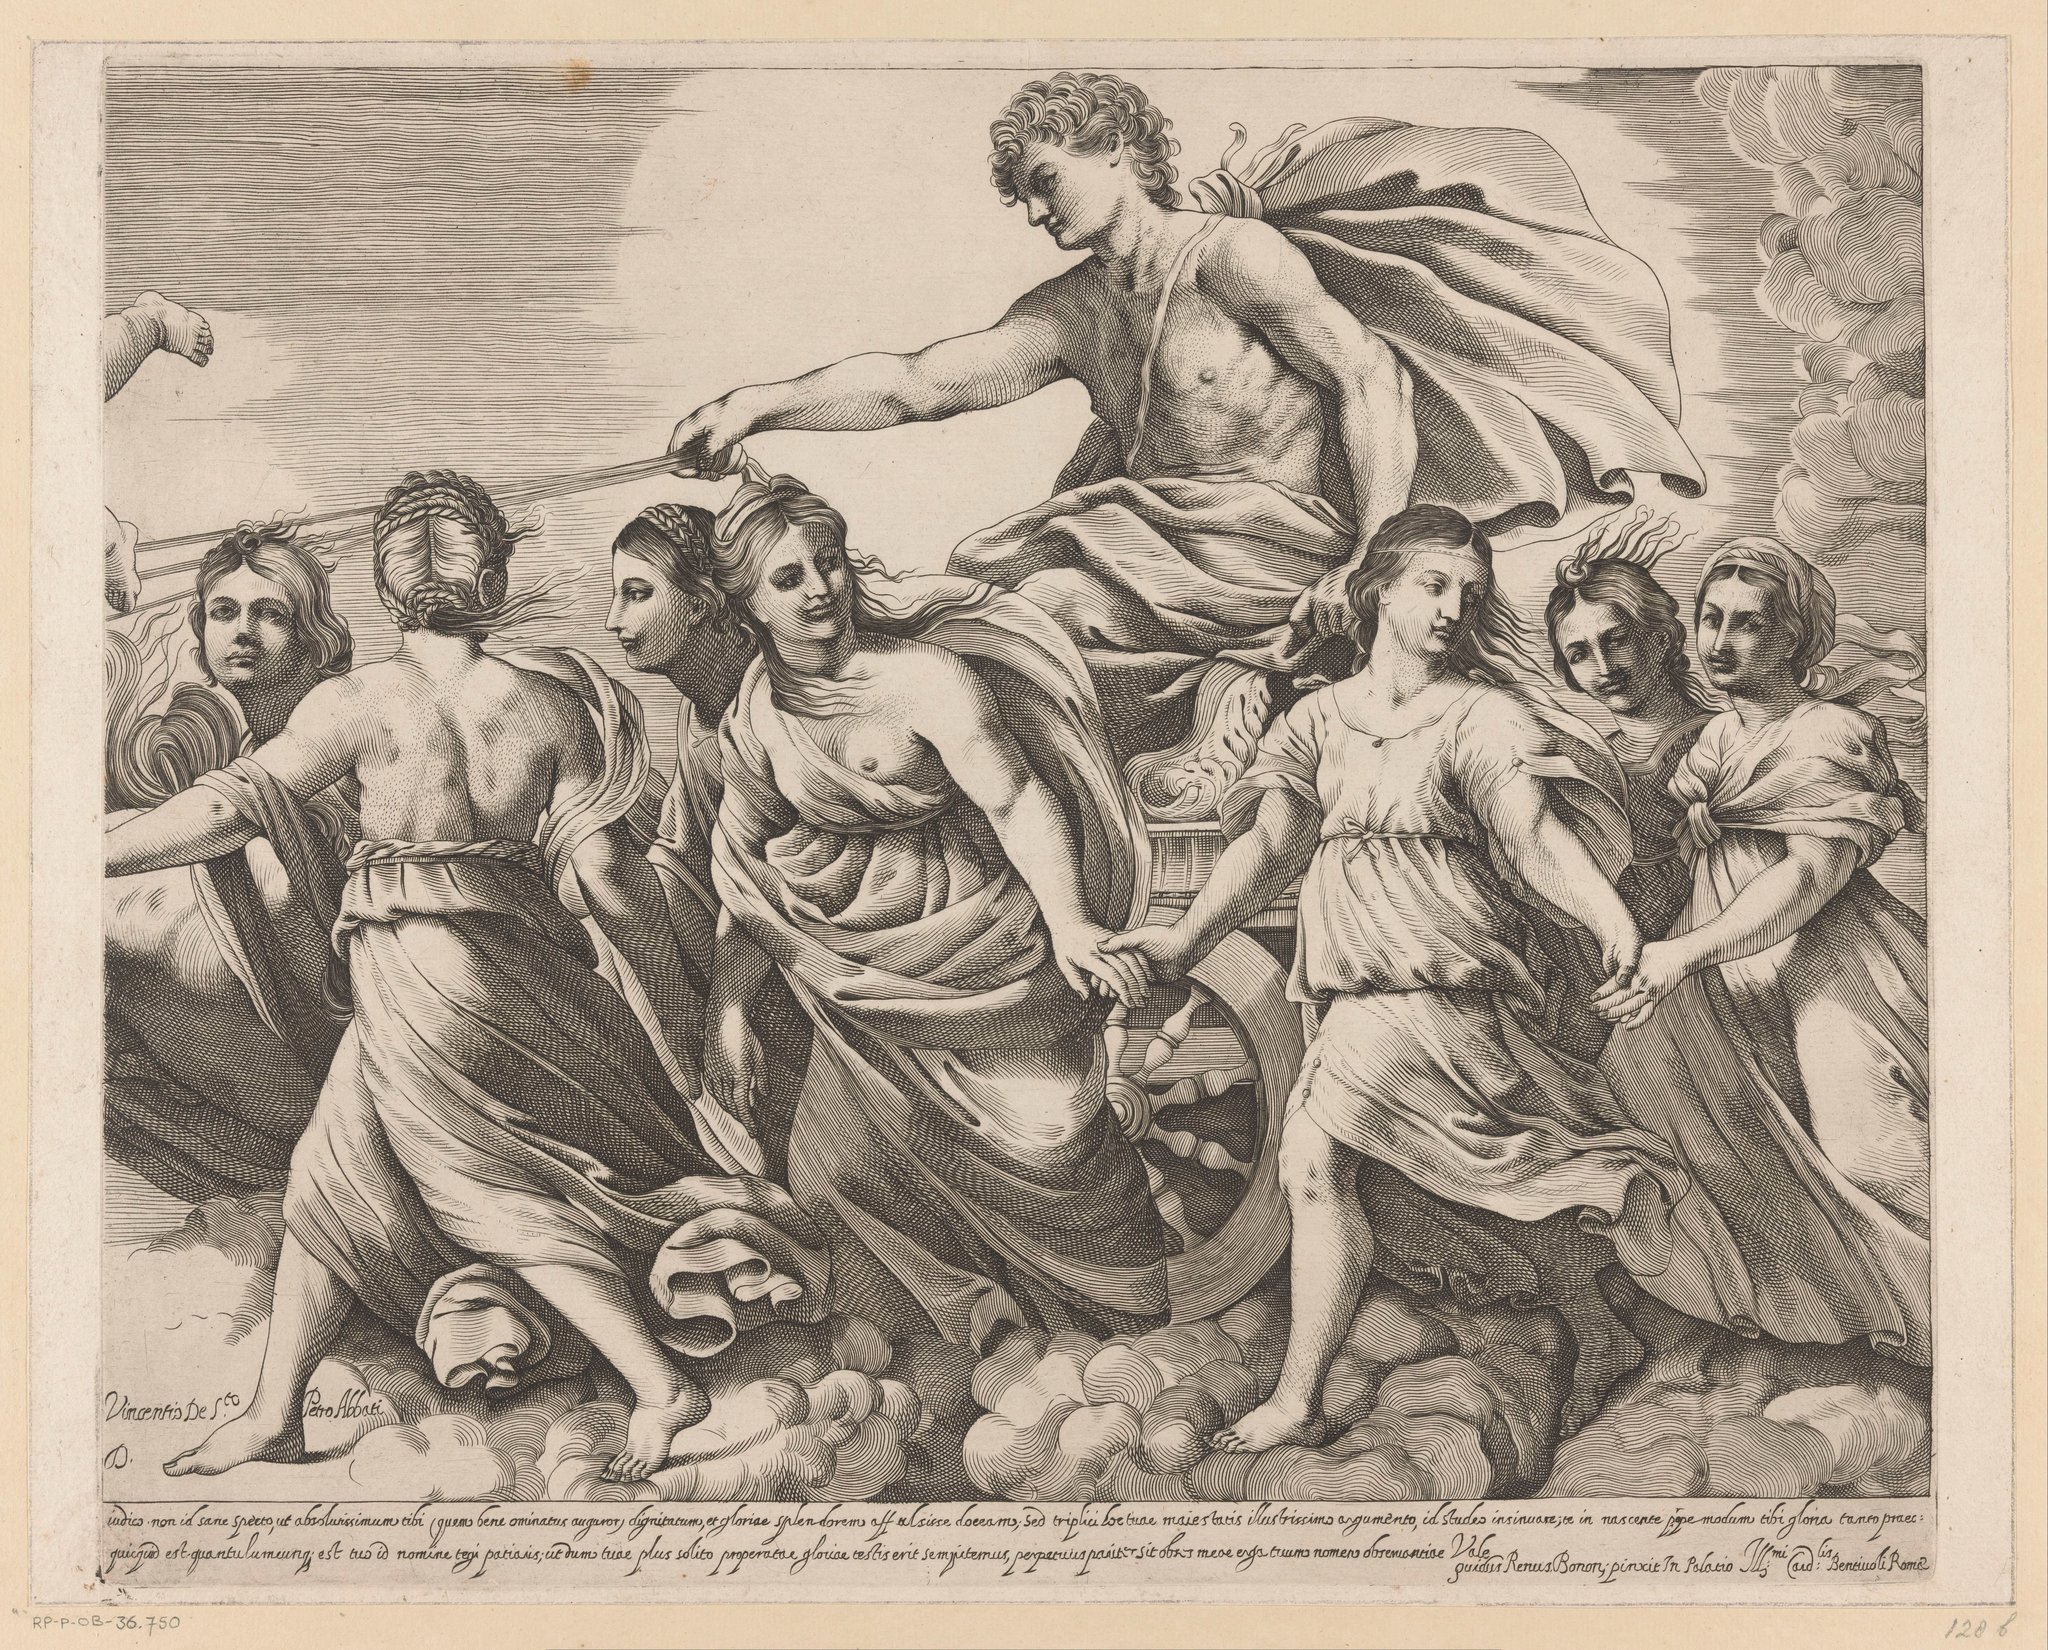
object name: print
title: Apollo en Aurora (rechterdeel)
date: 1622-1634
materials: paper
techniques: engraving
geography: vatican city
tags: apollo in the chariot of the sun, drawn by four horses, usually preceded by aurora holding a torch; 'carro del sole' (ripa), hours (horae), seasons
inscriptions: collector's mark: Lugt 240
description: Apollo de Zonnegod zit op zijn wagen die vooruit wordt getrokken door vier paarden. Om hem heen dansen de Horae, de godinnen van de jaargetijden. Voor hem uit zweven een putto met een fakkel en Aurora. Strooiend met bloemen verjaagt Aurora de nacht en brengt zij het ochtendgloren. Midden onder een wapenschild. Opdracht en tweeregelige tekst in het Latijn in de ondermarge.